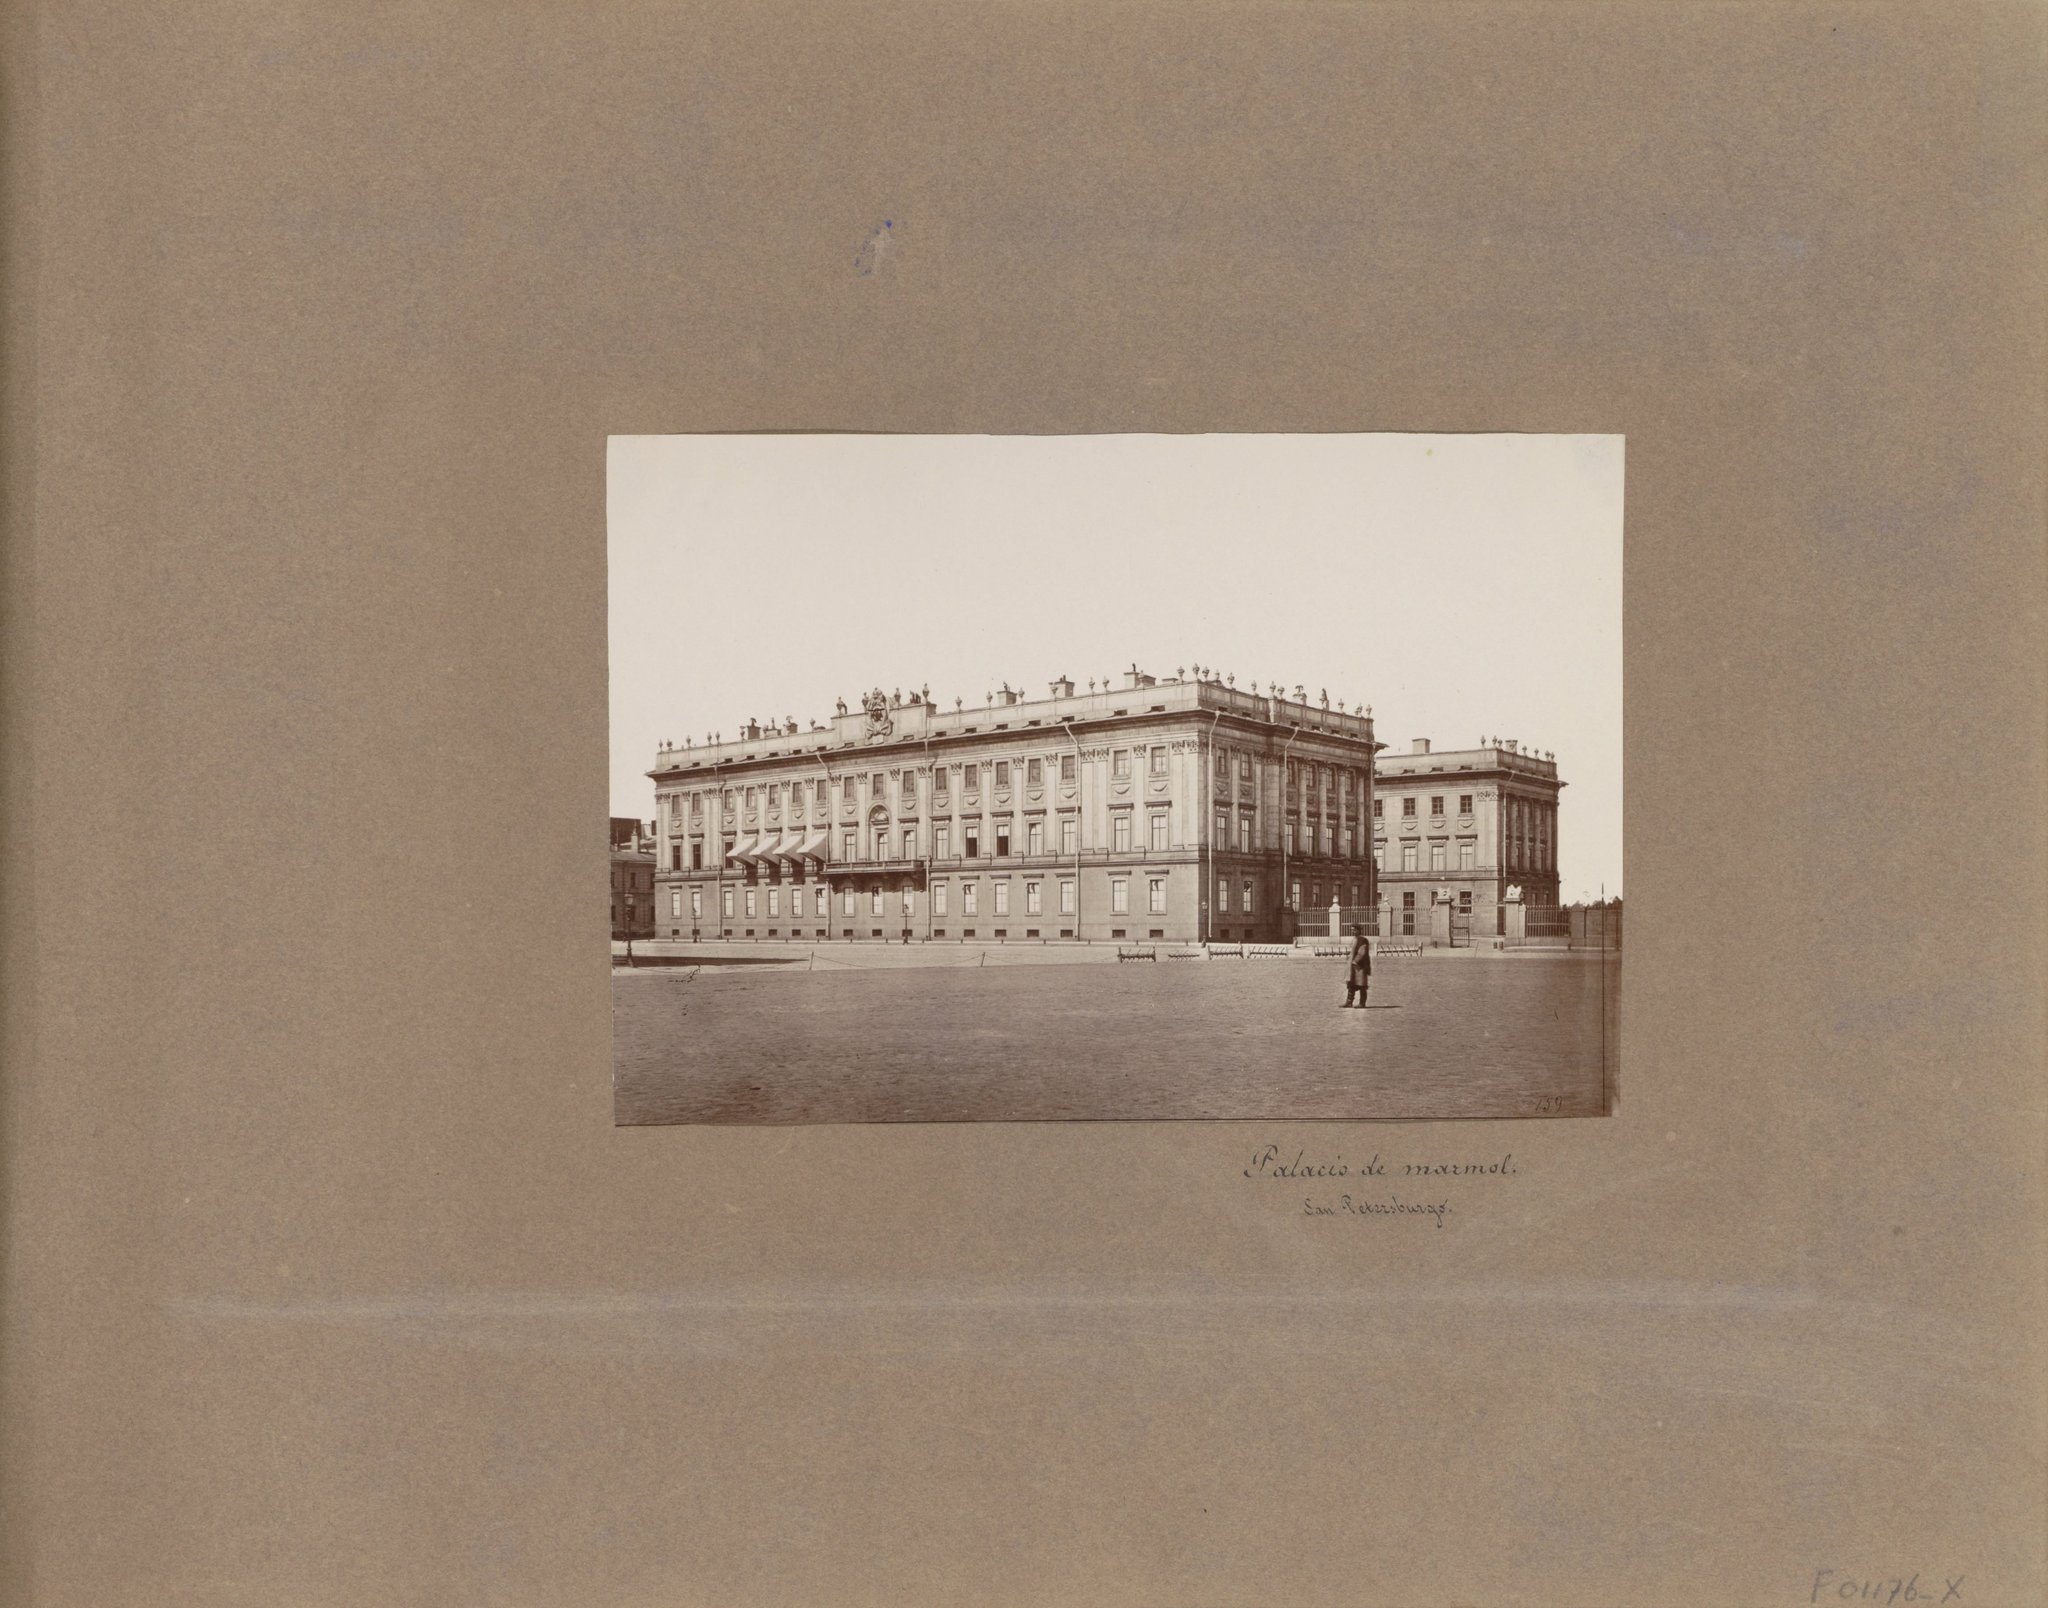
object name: photograph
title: Palacio de marmol. San Petersburgo.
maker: alfred lorens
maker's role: fotograaf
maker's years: 1830-1896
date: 1850-1876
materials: photographic support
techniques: albumen print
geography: sint-petersburg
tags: palace, travelling; tourism, square, place, circus, etc. (+ city(-scape) with figures, staffage)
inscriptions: negative number: ‘159’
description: Onderdeel van Reisalbum met foto's en tekeningen van Manuel Mayo 1876.